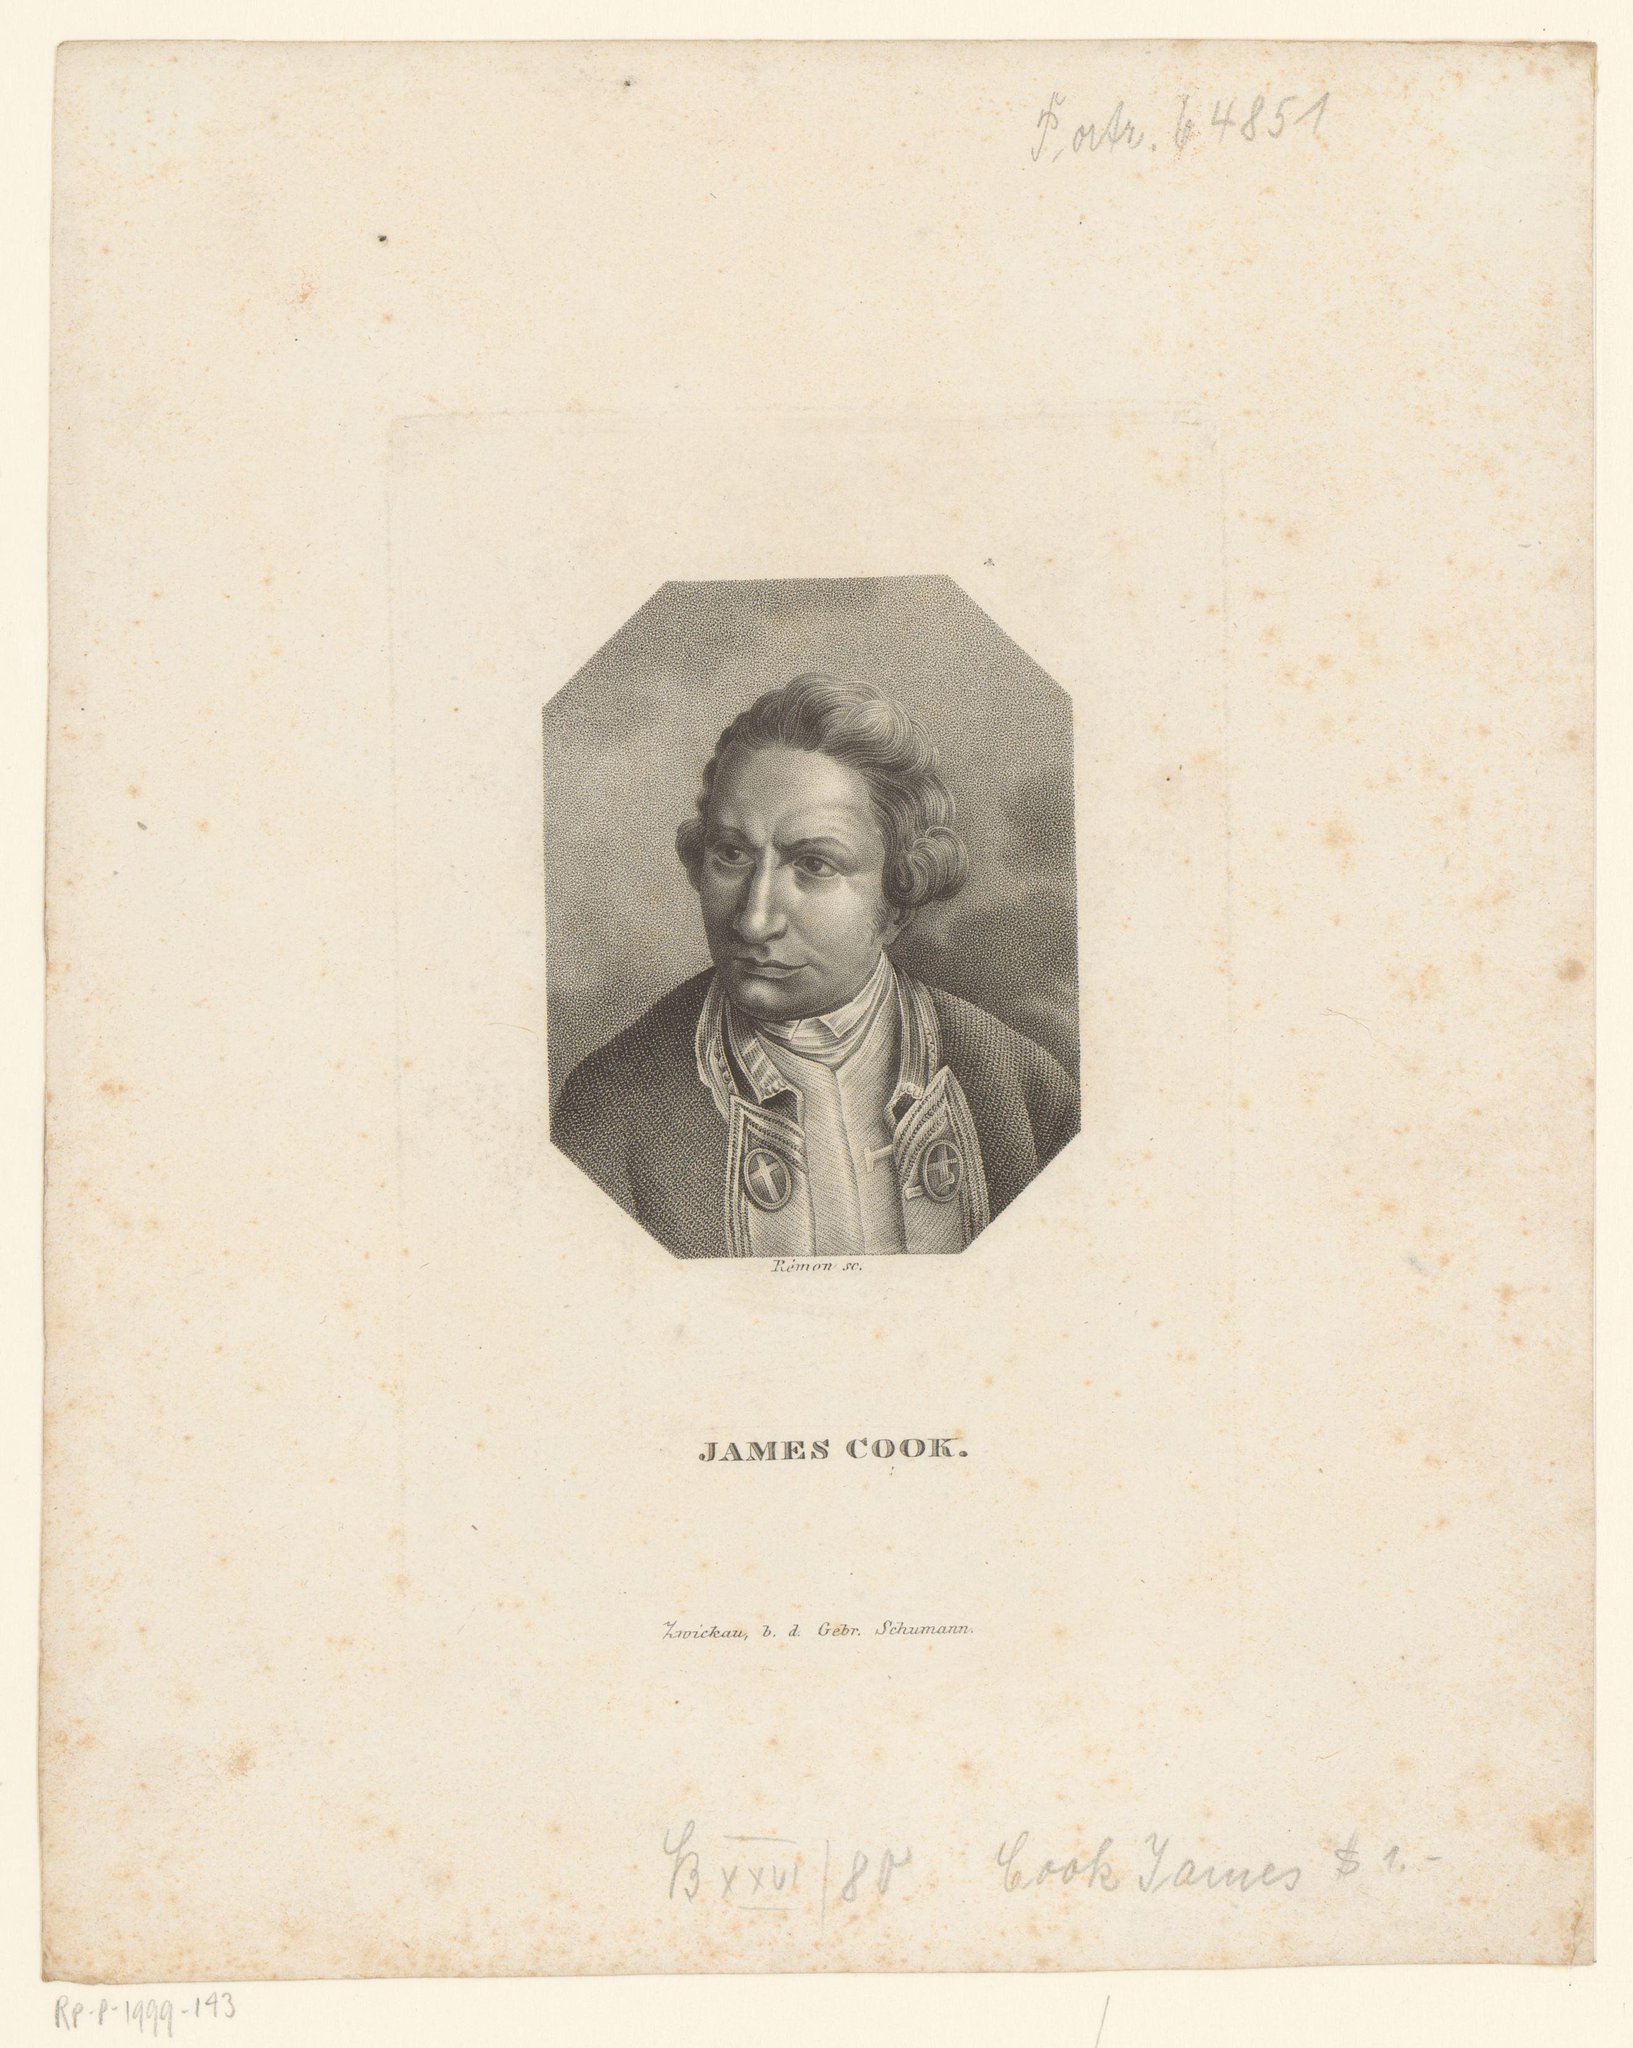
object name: print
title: Portret van James Cook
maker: j. rémon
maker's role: print maker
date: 1800-1899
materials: paper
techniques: stippling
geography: zwickau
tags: james cook, explorer (+ portrait of scholar, scientist), historical persons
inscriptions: collector's mark: Lugt 2228